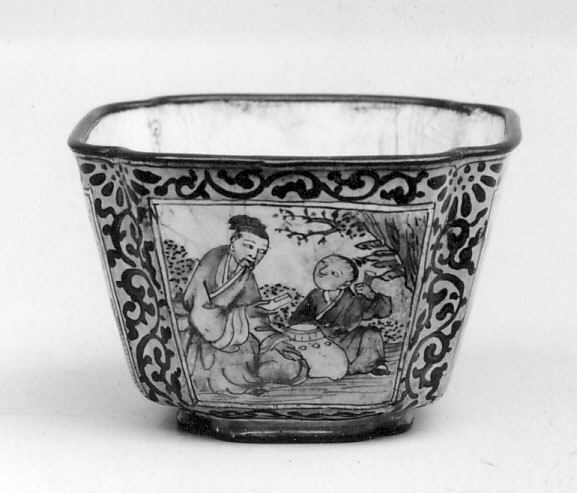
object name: cup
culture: chinese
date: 1736-1795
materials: enamel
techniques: painting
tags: boys,men